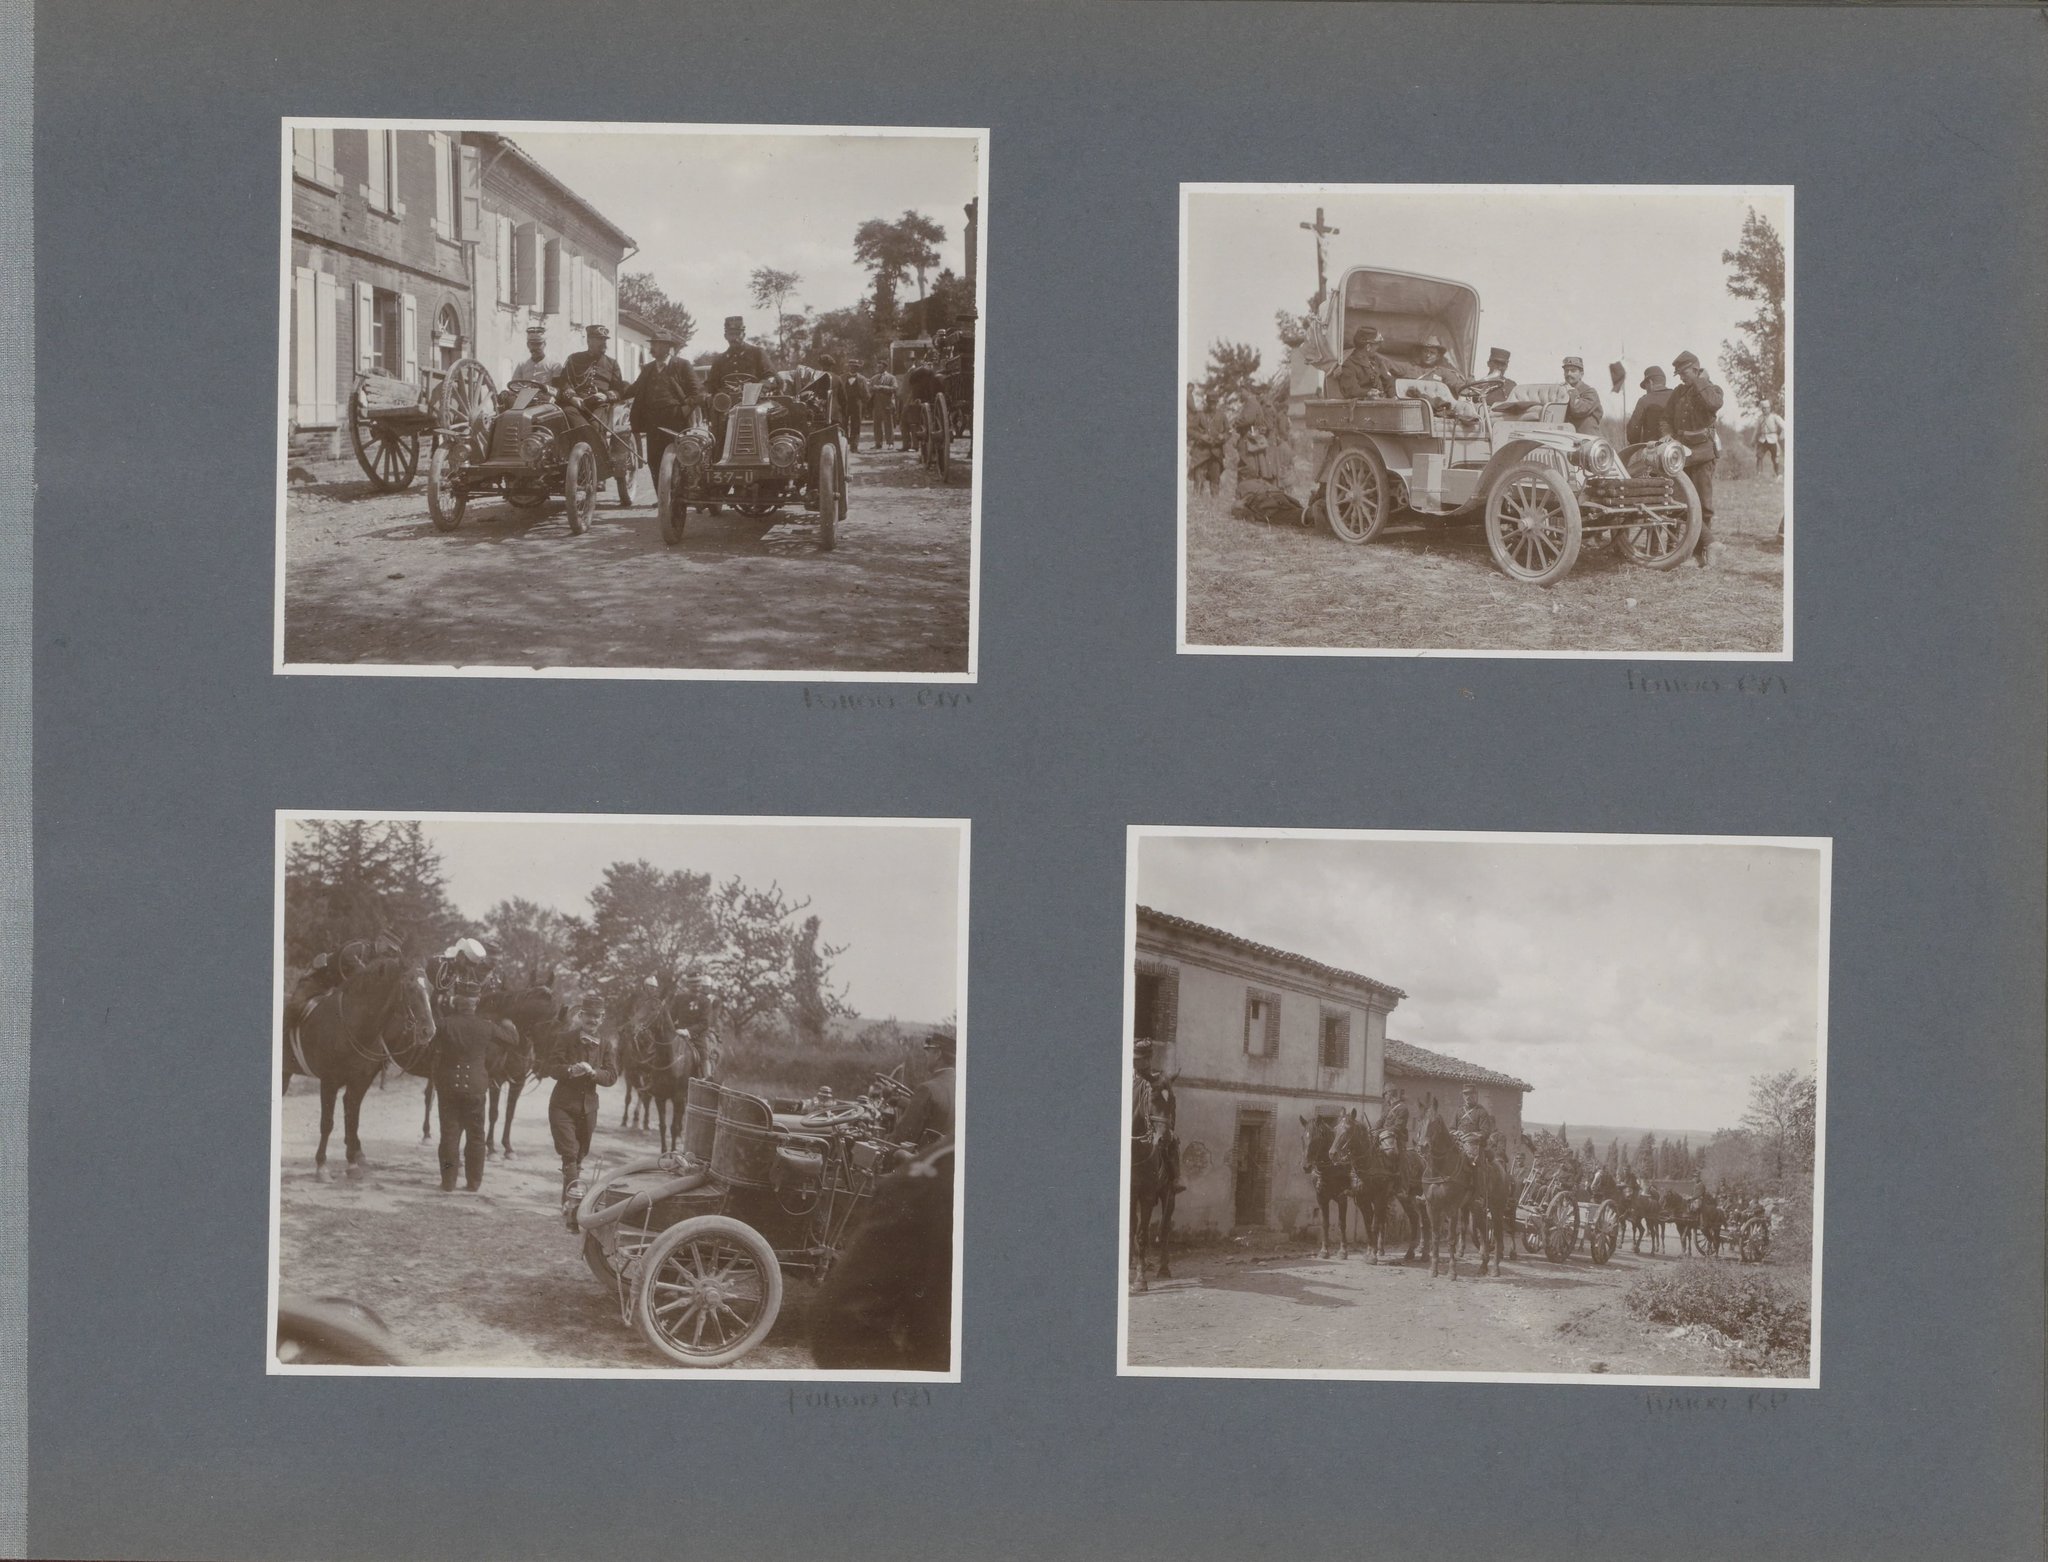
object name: photograph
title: Burgers bij militairen in auto's in een Frans dorp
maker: Anonymous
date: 1902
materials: paper, photographic support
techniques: daylight paper print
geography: france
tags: land forces, soldiers and civilians, automobile, france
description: Onderdeel van Fotoalbum van een legeroefening in Zuidwest-Frankrijk in 1902.